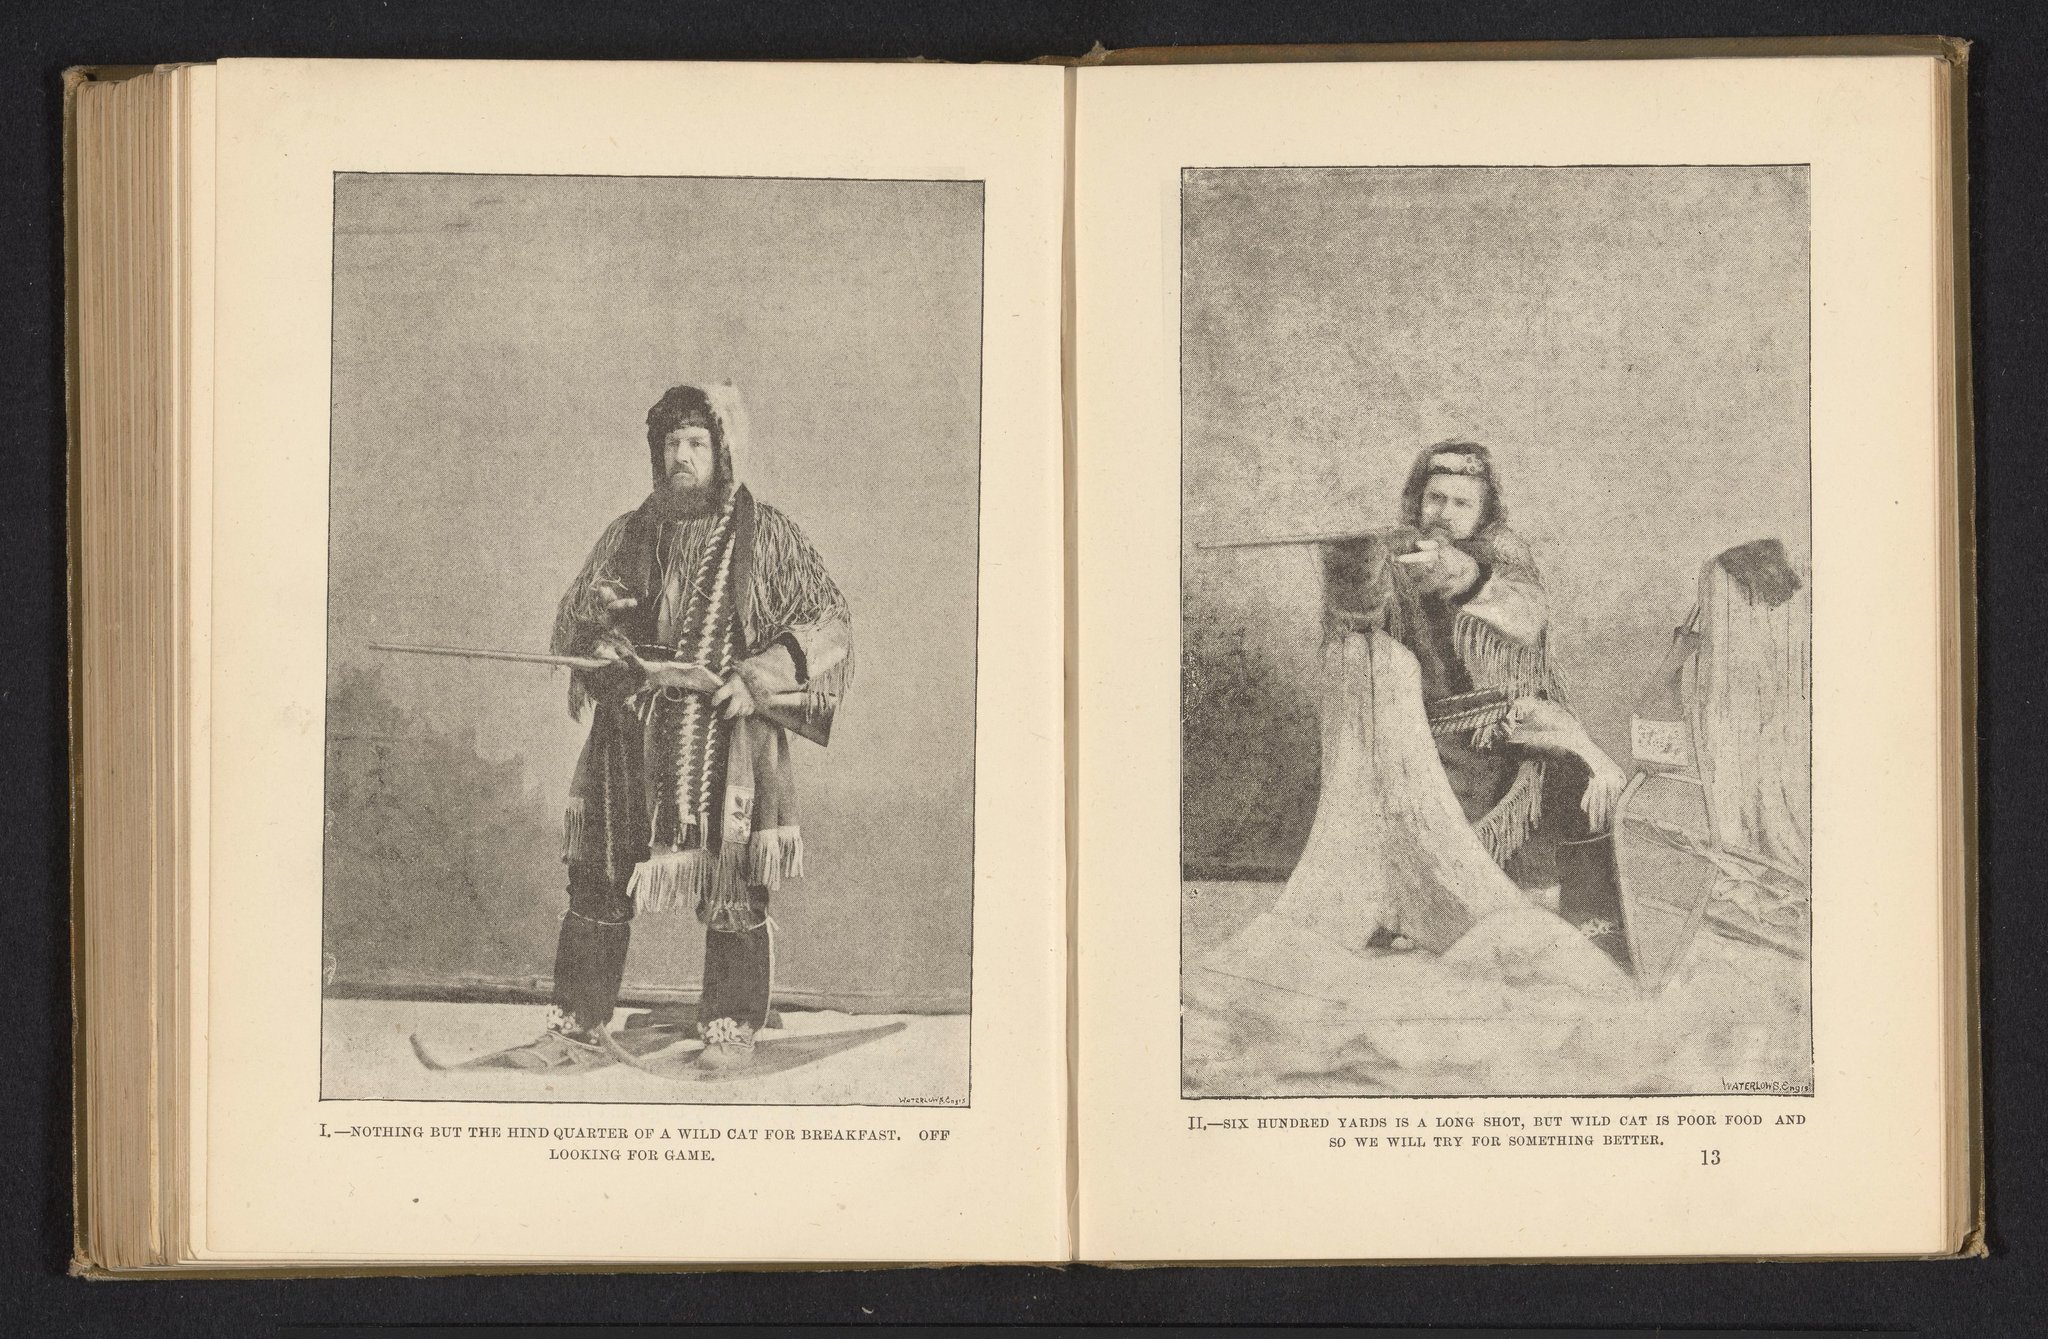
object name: photomechanical print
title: II.-Six hundred yards is a long shot, but wild cat is poor food and so we will try for something better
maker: Anonymous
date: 1882-1892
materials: paper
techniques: autotype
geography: canada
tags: missionary, egerton ryerson young, hunter, firearms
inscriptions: number: ‘13’